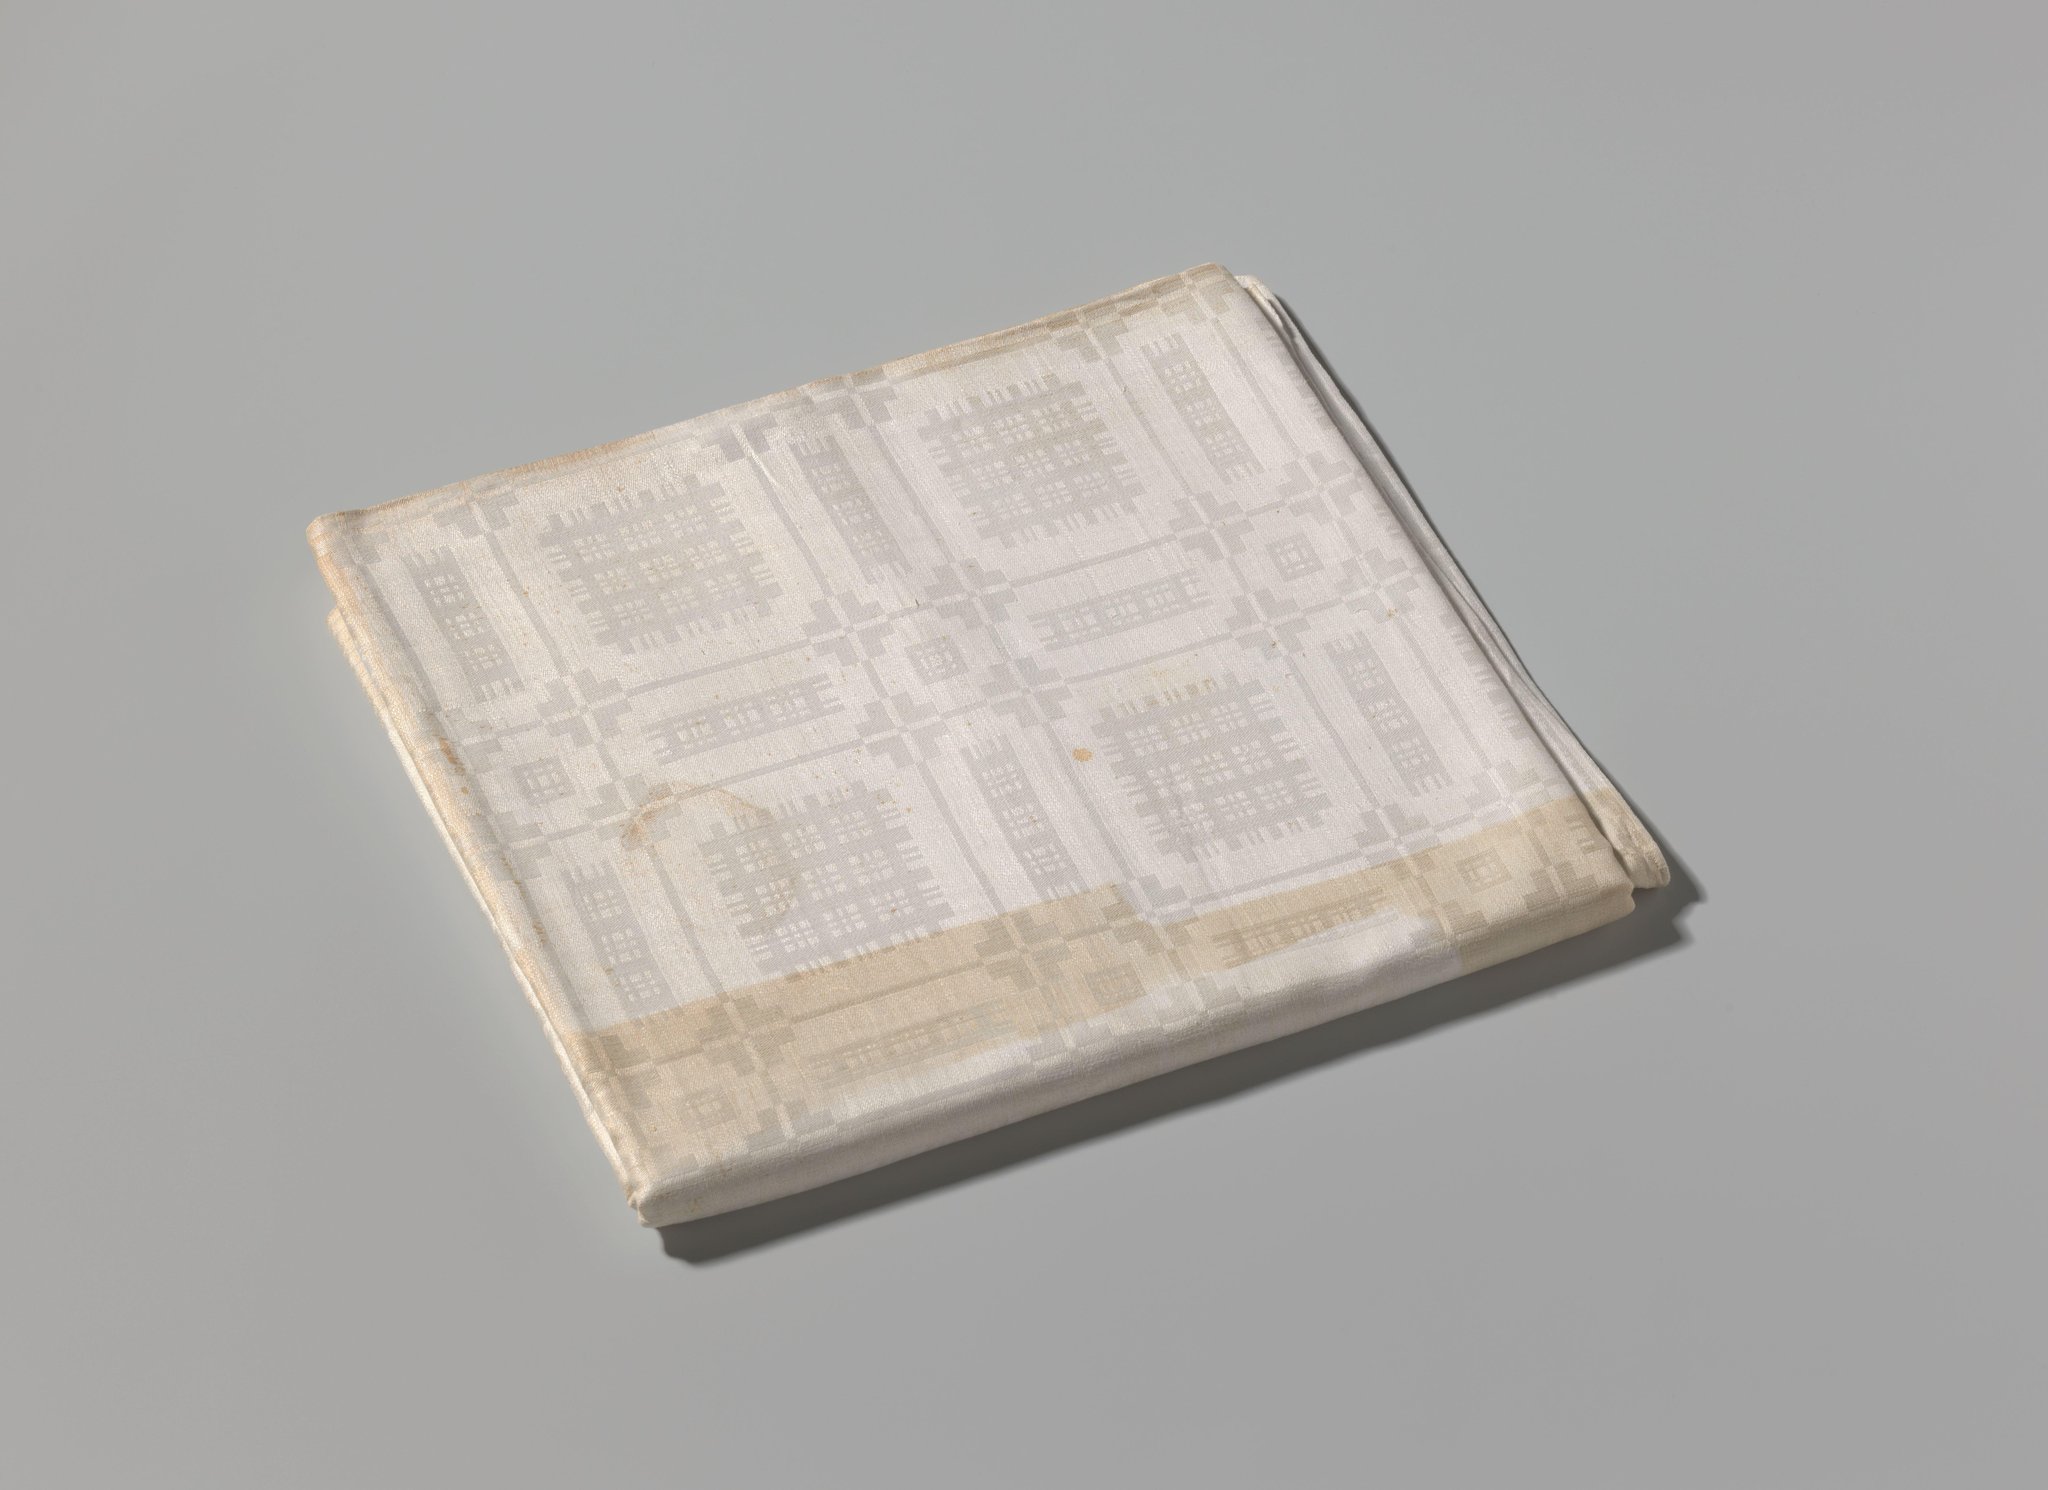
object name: tablecloth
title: Tafellaken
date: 1852-1872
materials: linen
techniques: peeled fabric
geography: northern netherlands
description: Wit linnen tafellaken met pellen patroon. Merk H.